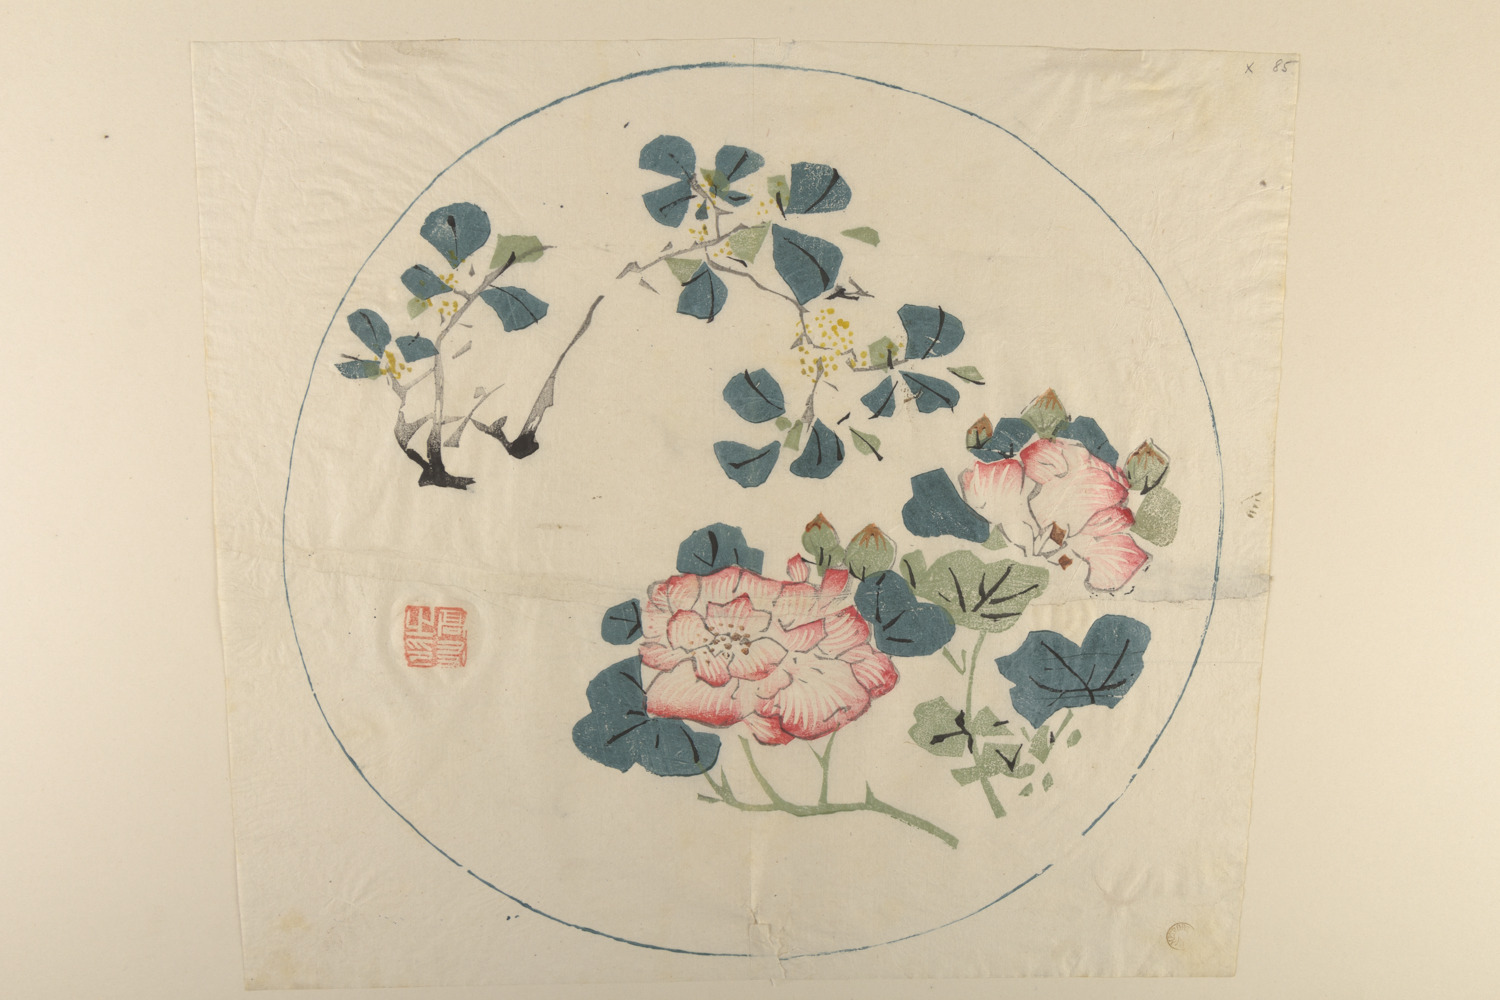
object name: print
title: Page from Shi Zhu Zhai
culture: chinese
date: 1736-1795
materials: ink, paper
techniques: polychrome, woodblock print